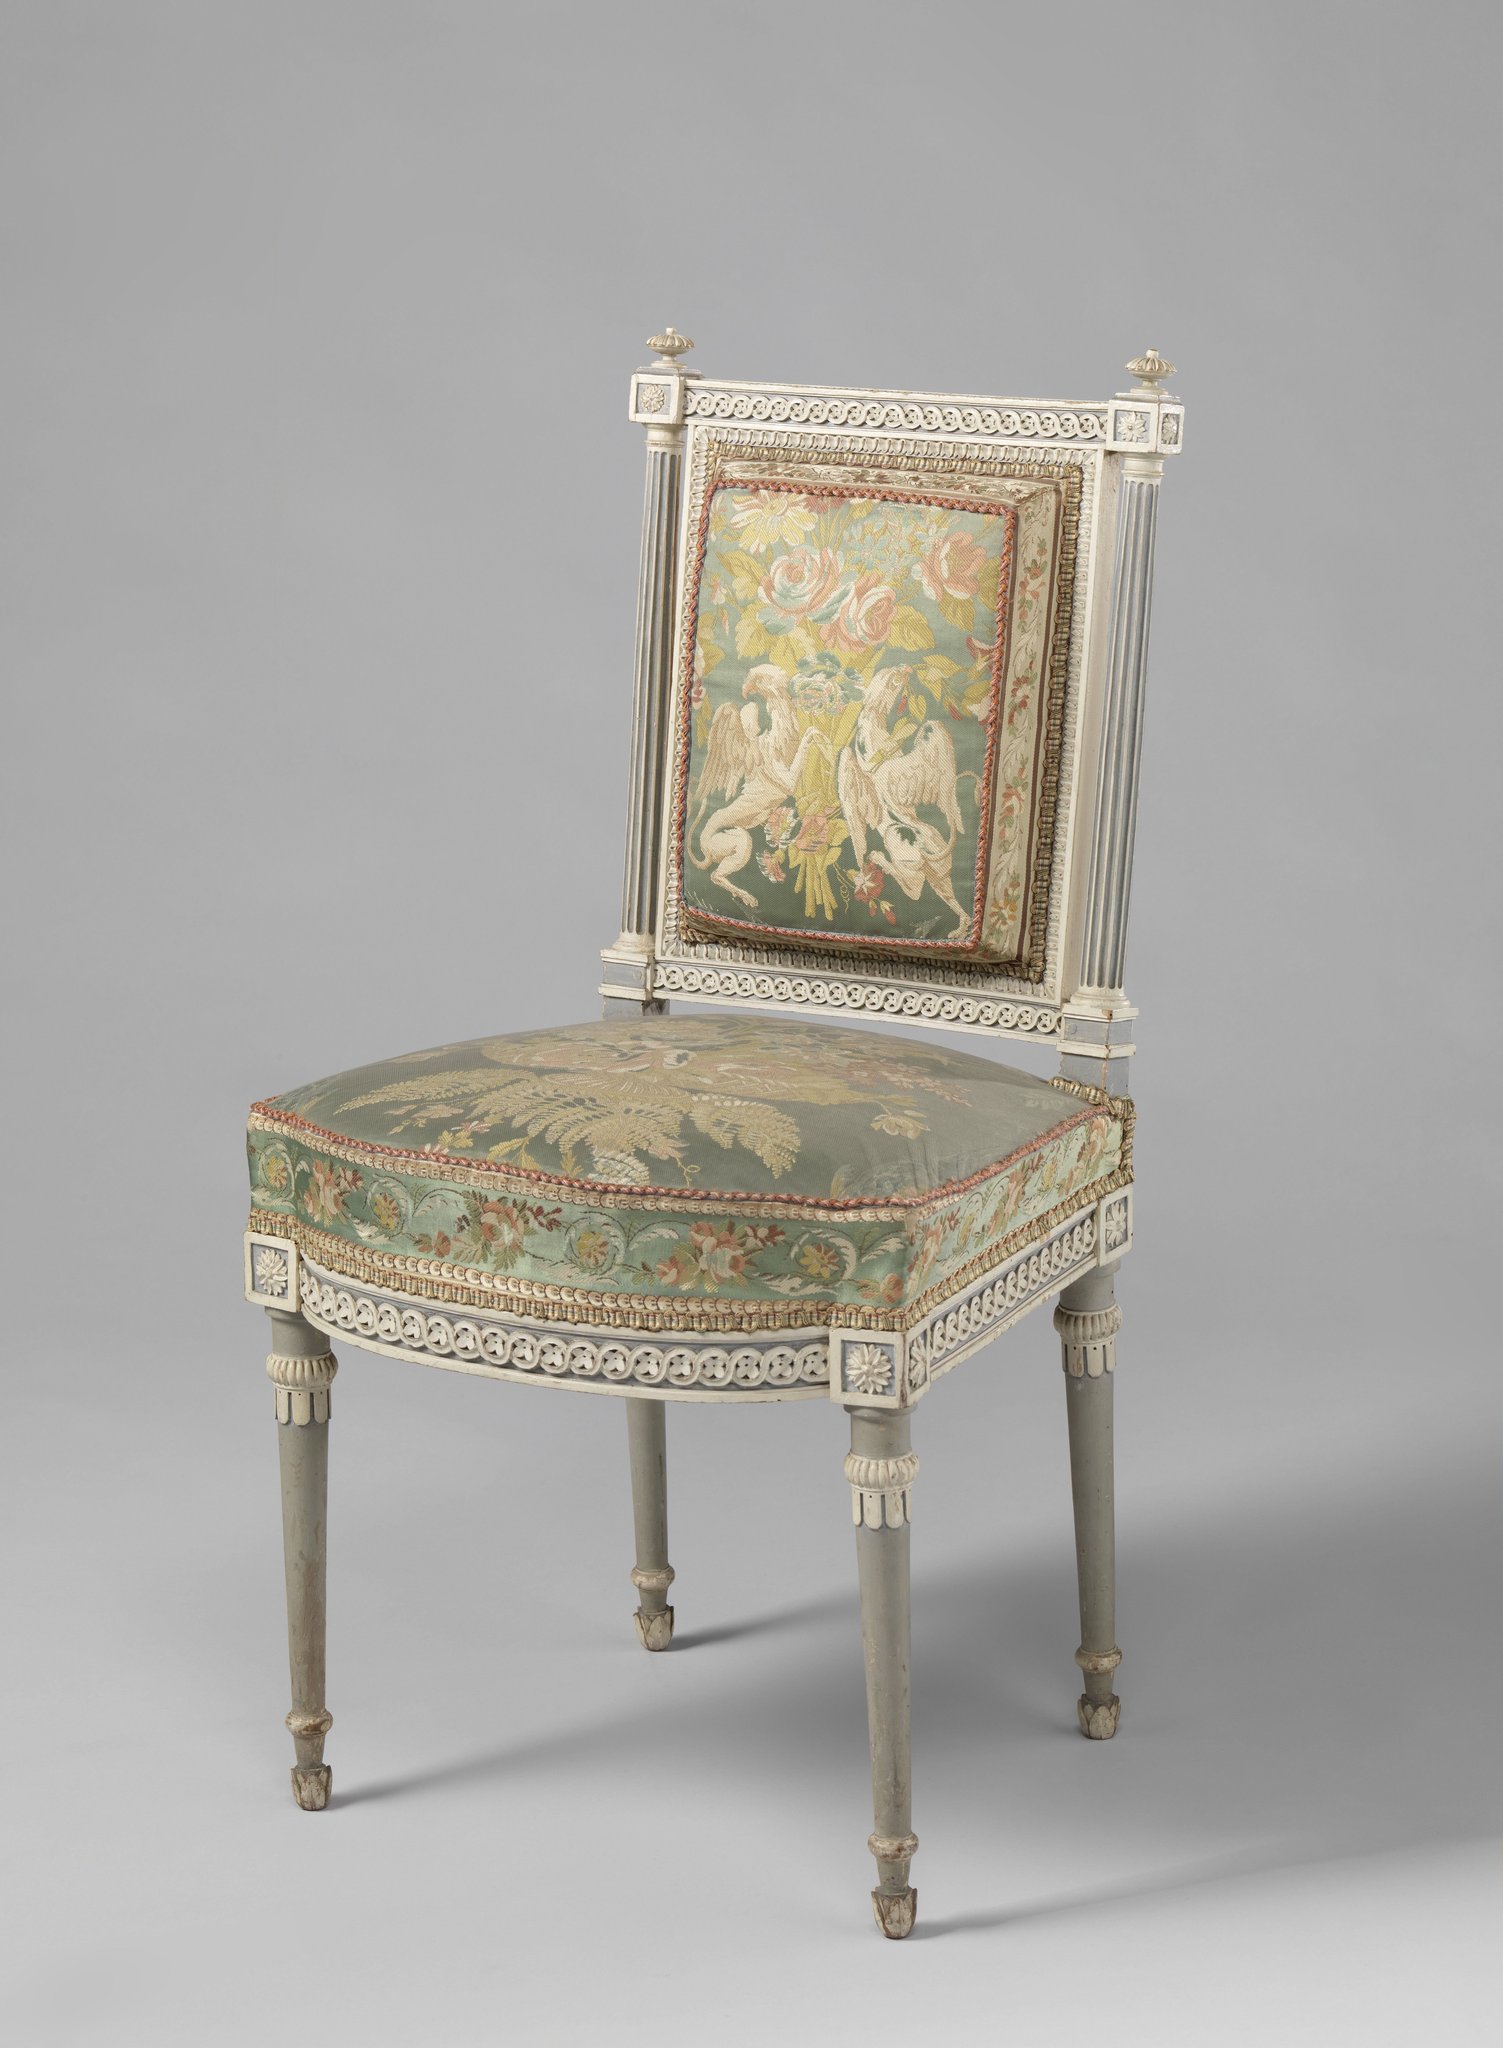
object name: chair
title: Stoel Kops-ameublement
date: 1793-1795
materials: wood, silk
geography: netherlands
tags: griffin (lion/eagle); 'griffo' (ripa), flowers ~ ornament